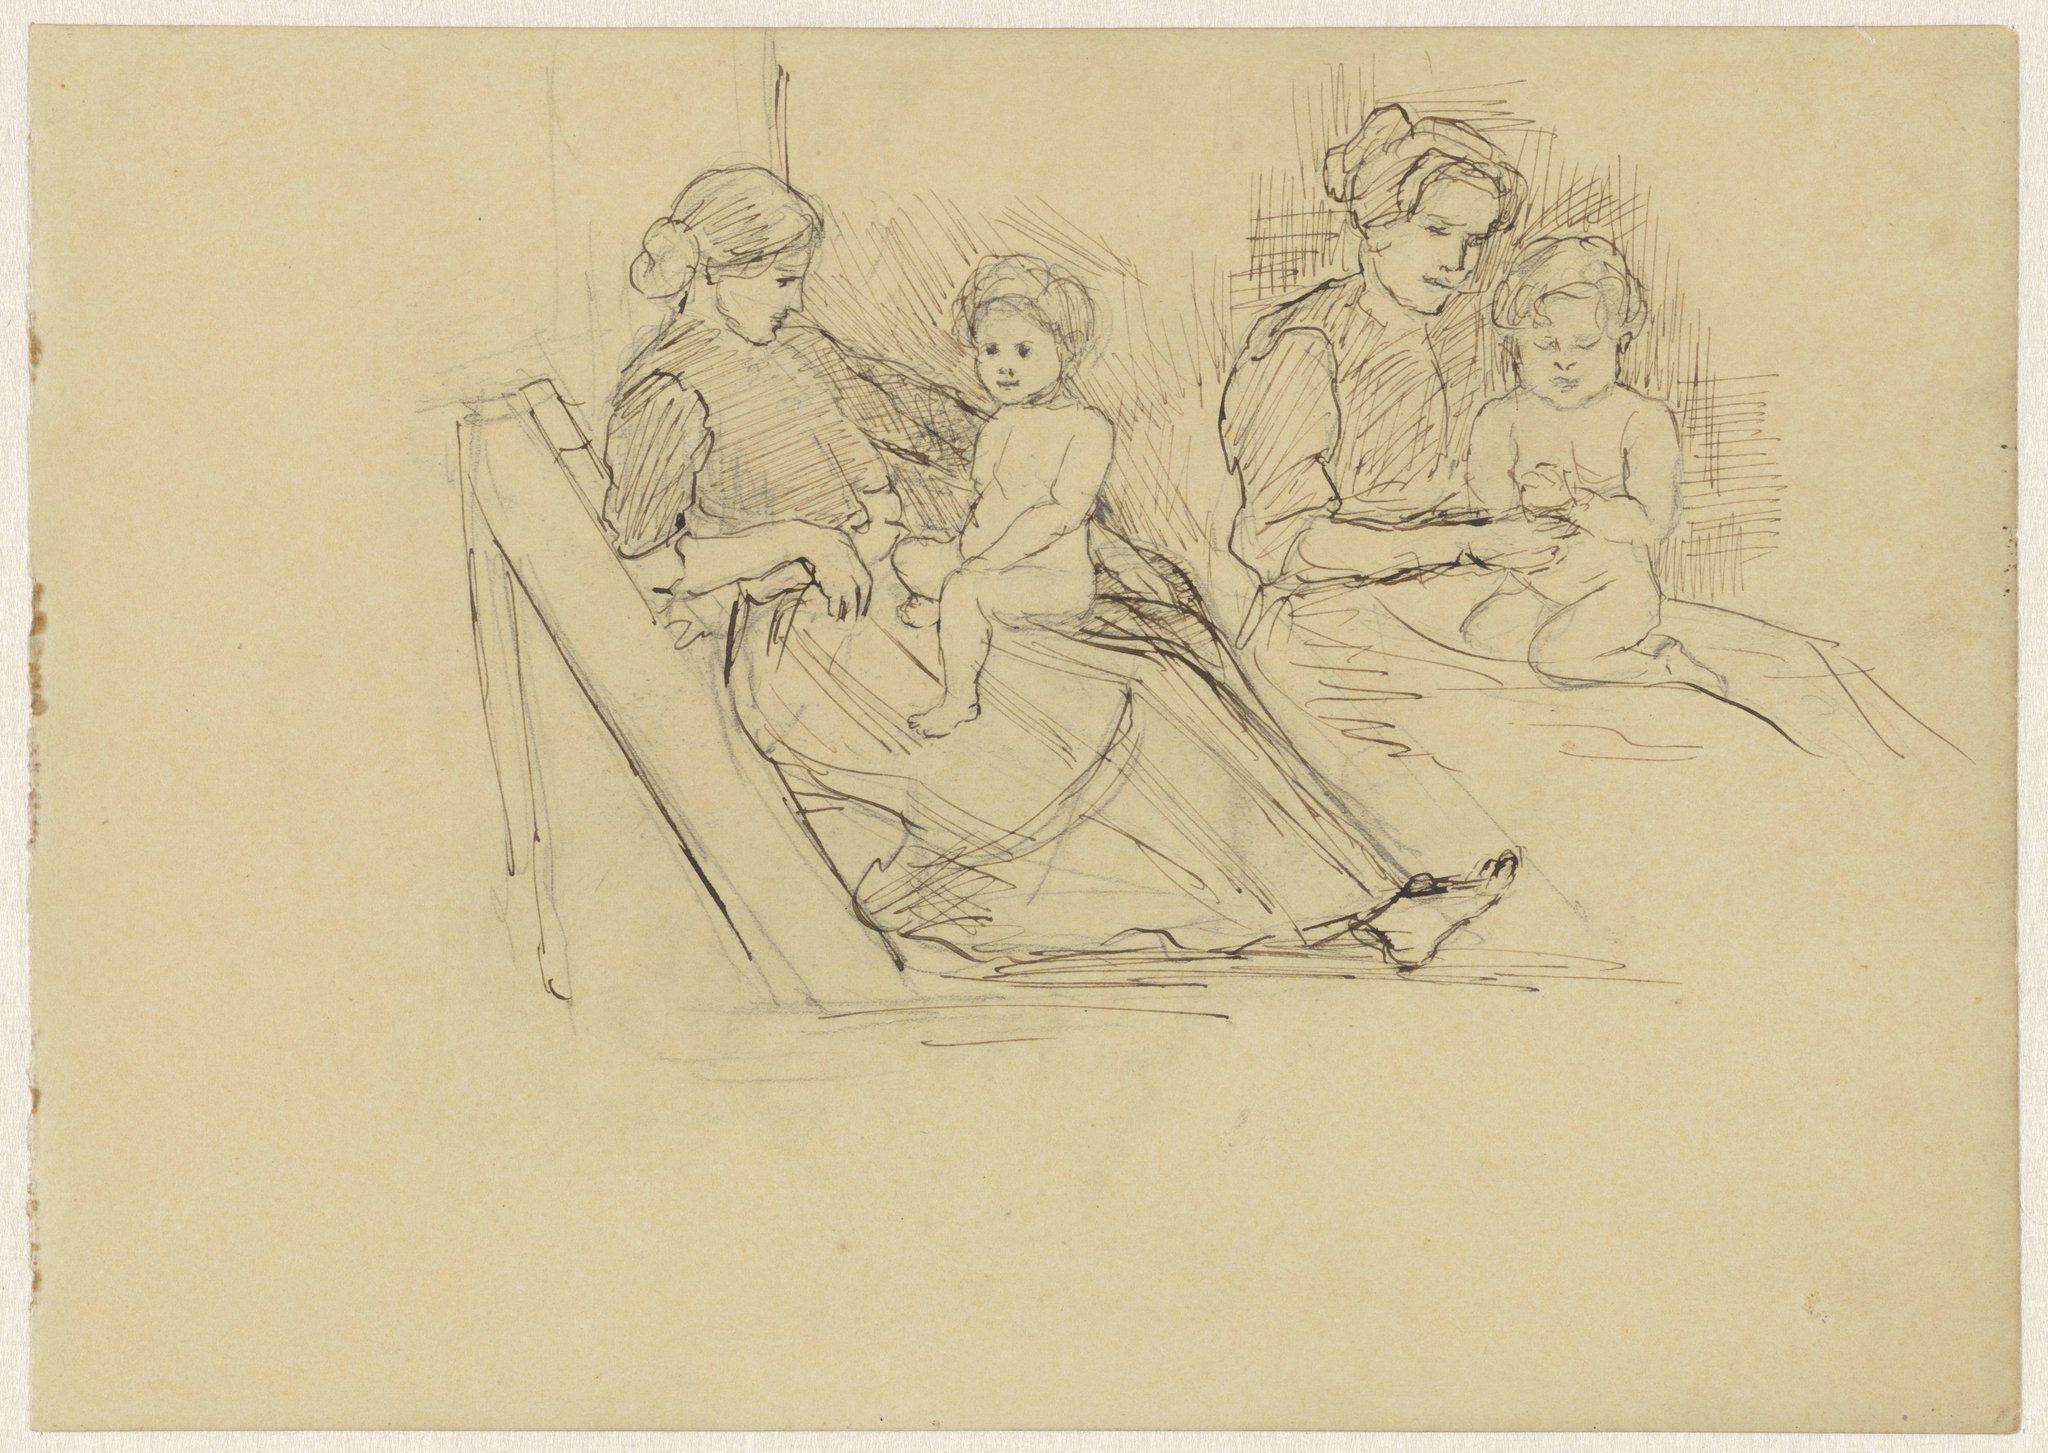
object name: drawing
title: Twee studies van een vrouw met kind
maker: jozef israëls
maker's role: draughtsman, painter, print maker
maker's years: 1824-1911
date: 1834-1911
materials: ink, paper, pencil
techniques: pen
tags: mother and baby or young child